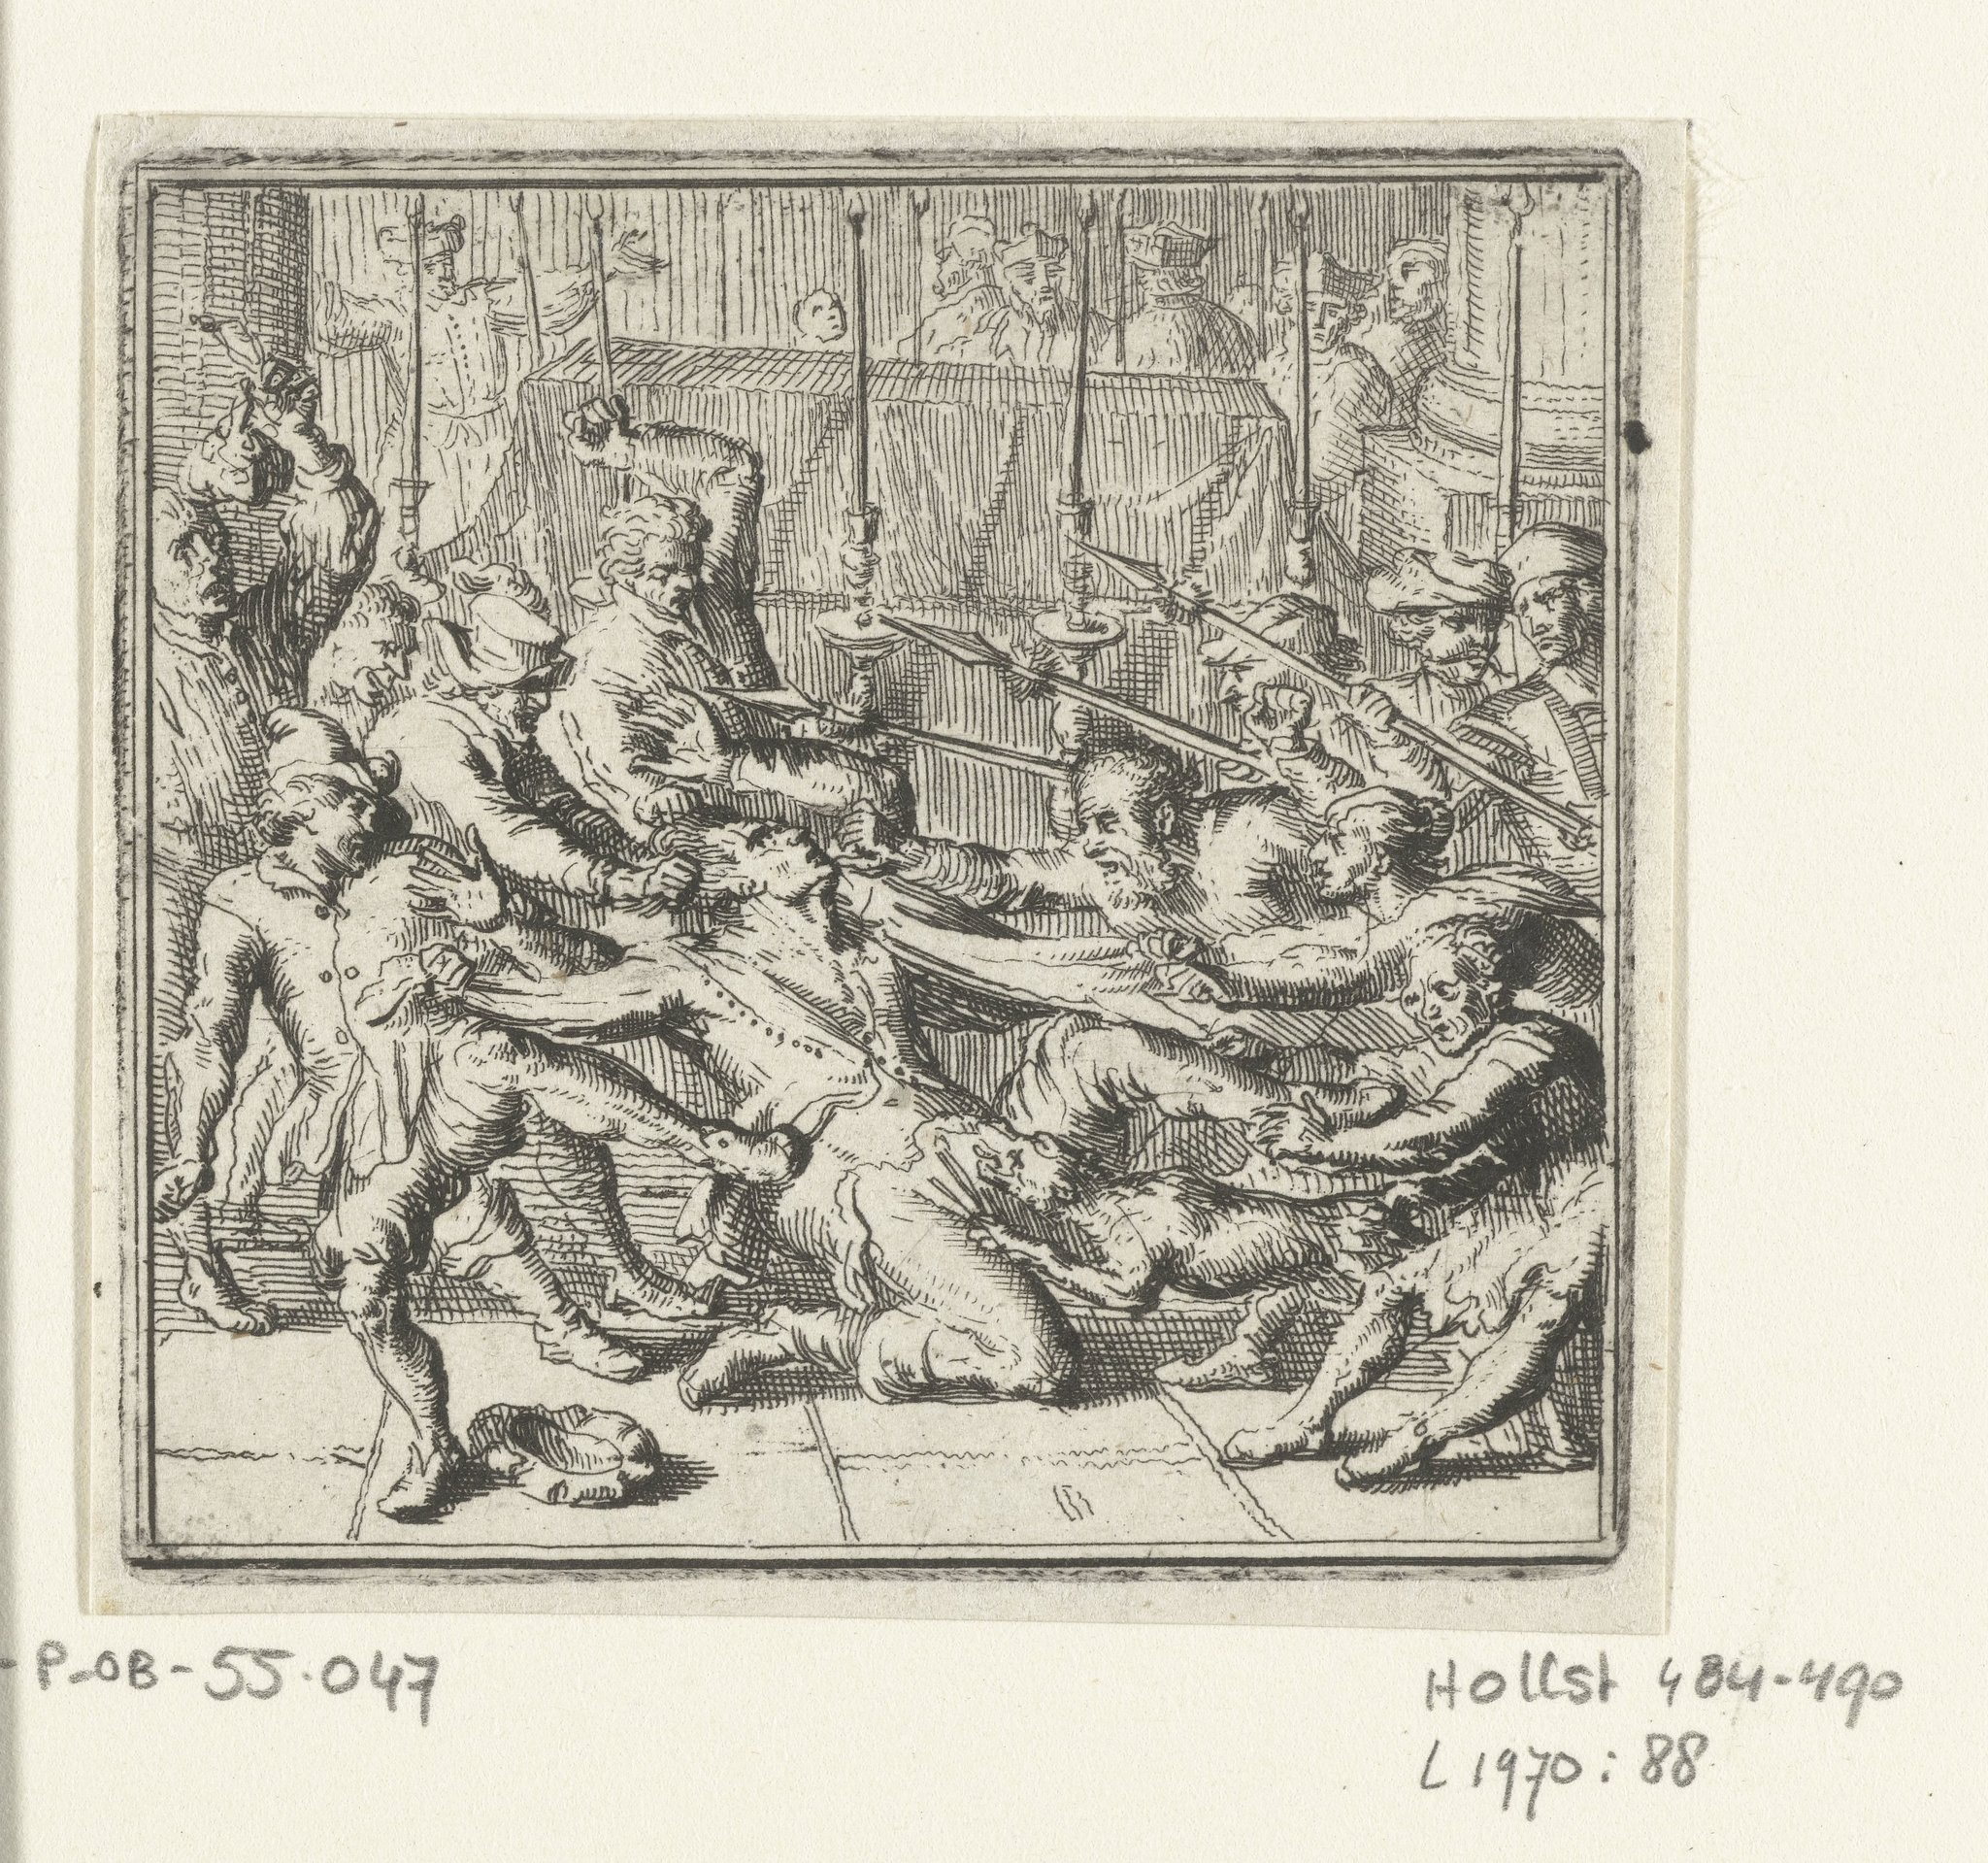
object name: print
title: Illustratie voor de Decamerone van Boccaccio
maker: romeyn de hooghe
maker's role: draughtsman, goldsmith, painter, print maker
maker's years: 1645-1708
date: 1697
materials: paper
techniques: etching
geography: netherlands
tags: (scenes from) specific works of literature: boccaccio, decamerone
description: Illustratie voor: Contes et nouvelles de Bocace Florentin. Traduction libre, 2 delen, Amsterdam, George Gallet, 1697. Latere edities met dezelfde illustraties uit 1699, 1702, 1732.